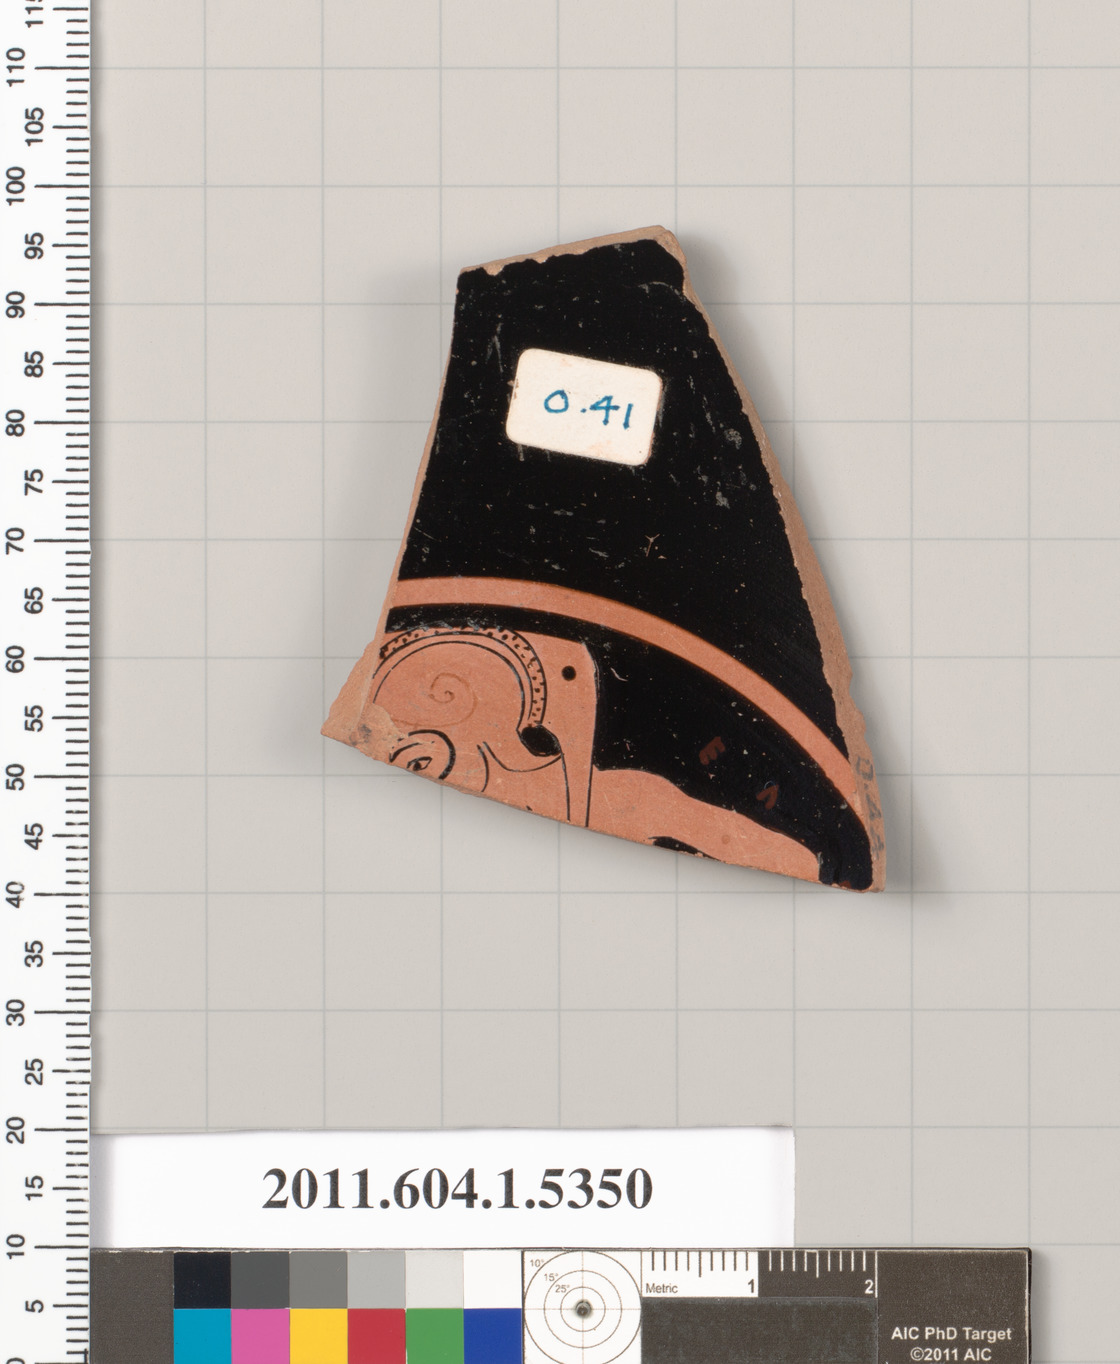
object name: kylix fragment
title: Terracotta fragment of a kylix (drinking cup)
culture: greek, attic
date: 520-500 BCE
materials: terracotta